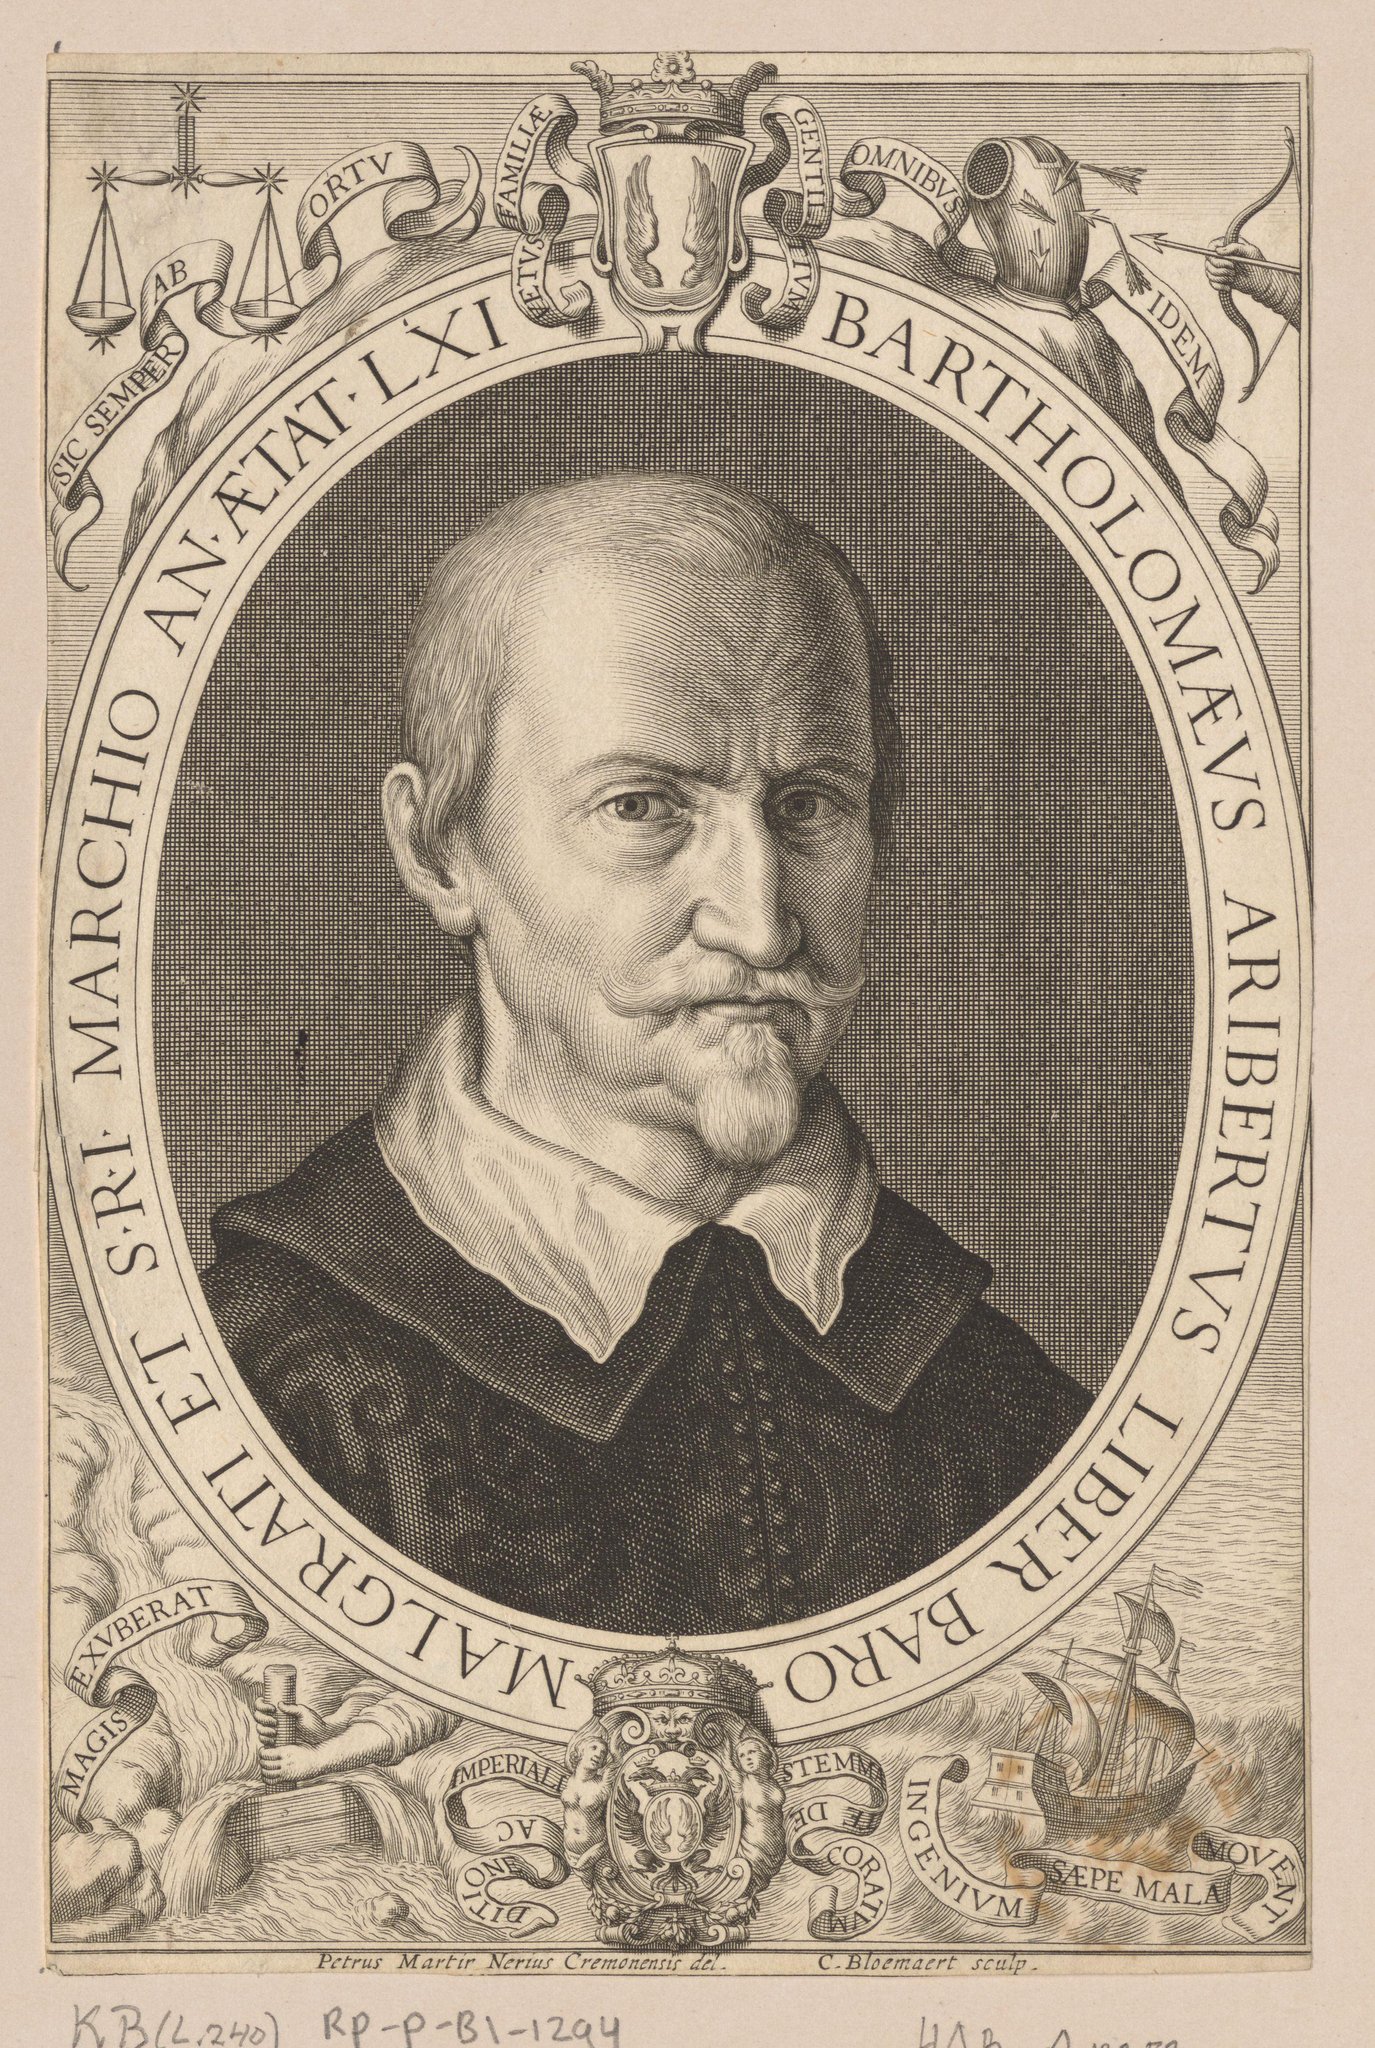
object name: print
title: Portret van Bartolommeo Ariberto de Malgrati op 61-jarige leeftijd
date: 1620-1659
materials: paper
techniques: engraving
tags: sailing-ship, sailing-boat, archer's weapons: bow and arrow, ornament ~ medallion, historical persons, scales, armorial bearing, heraldry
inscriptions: collector's mark: ‘P. mariette 1659’ Lugt 1788, collector's mark: Lugt 240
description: Met randschrift in het Latijn en verschillende motto's in het Latijn rondom het portret.